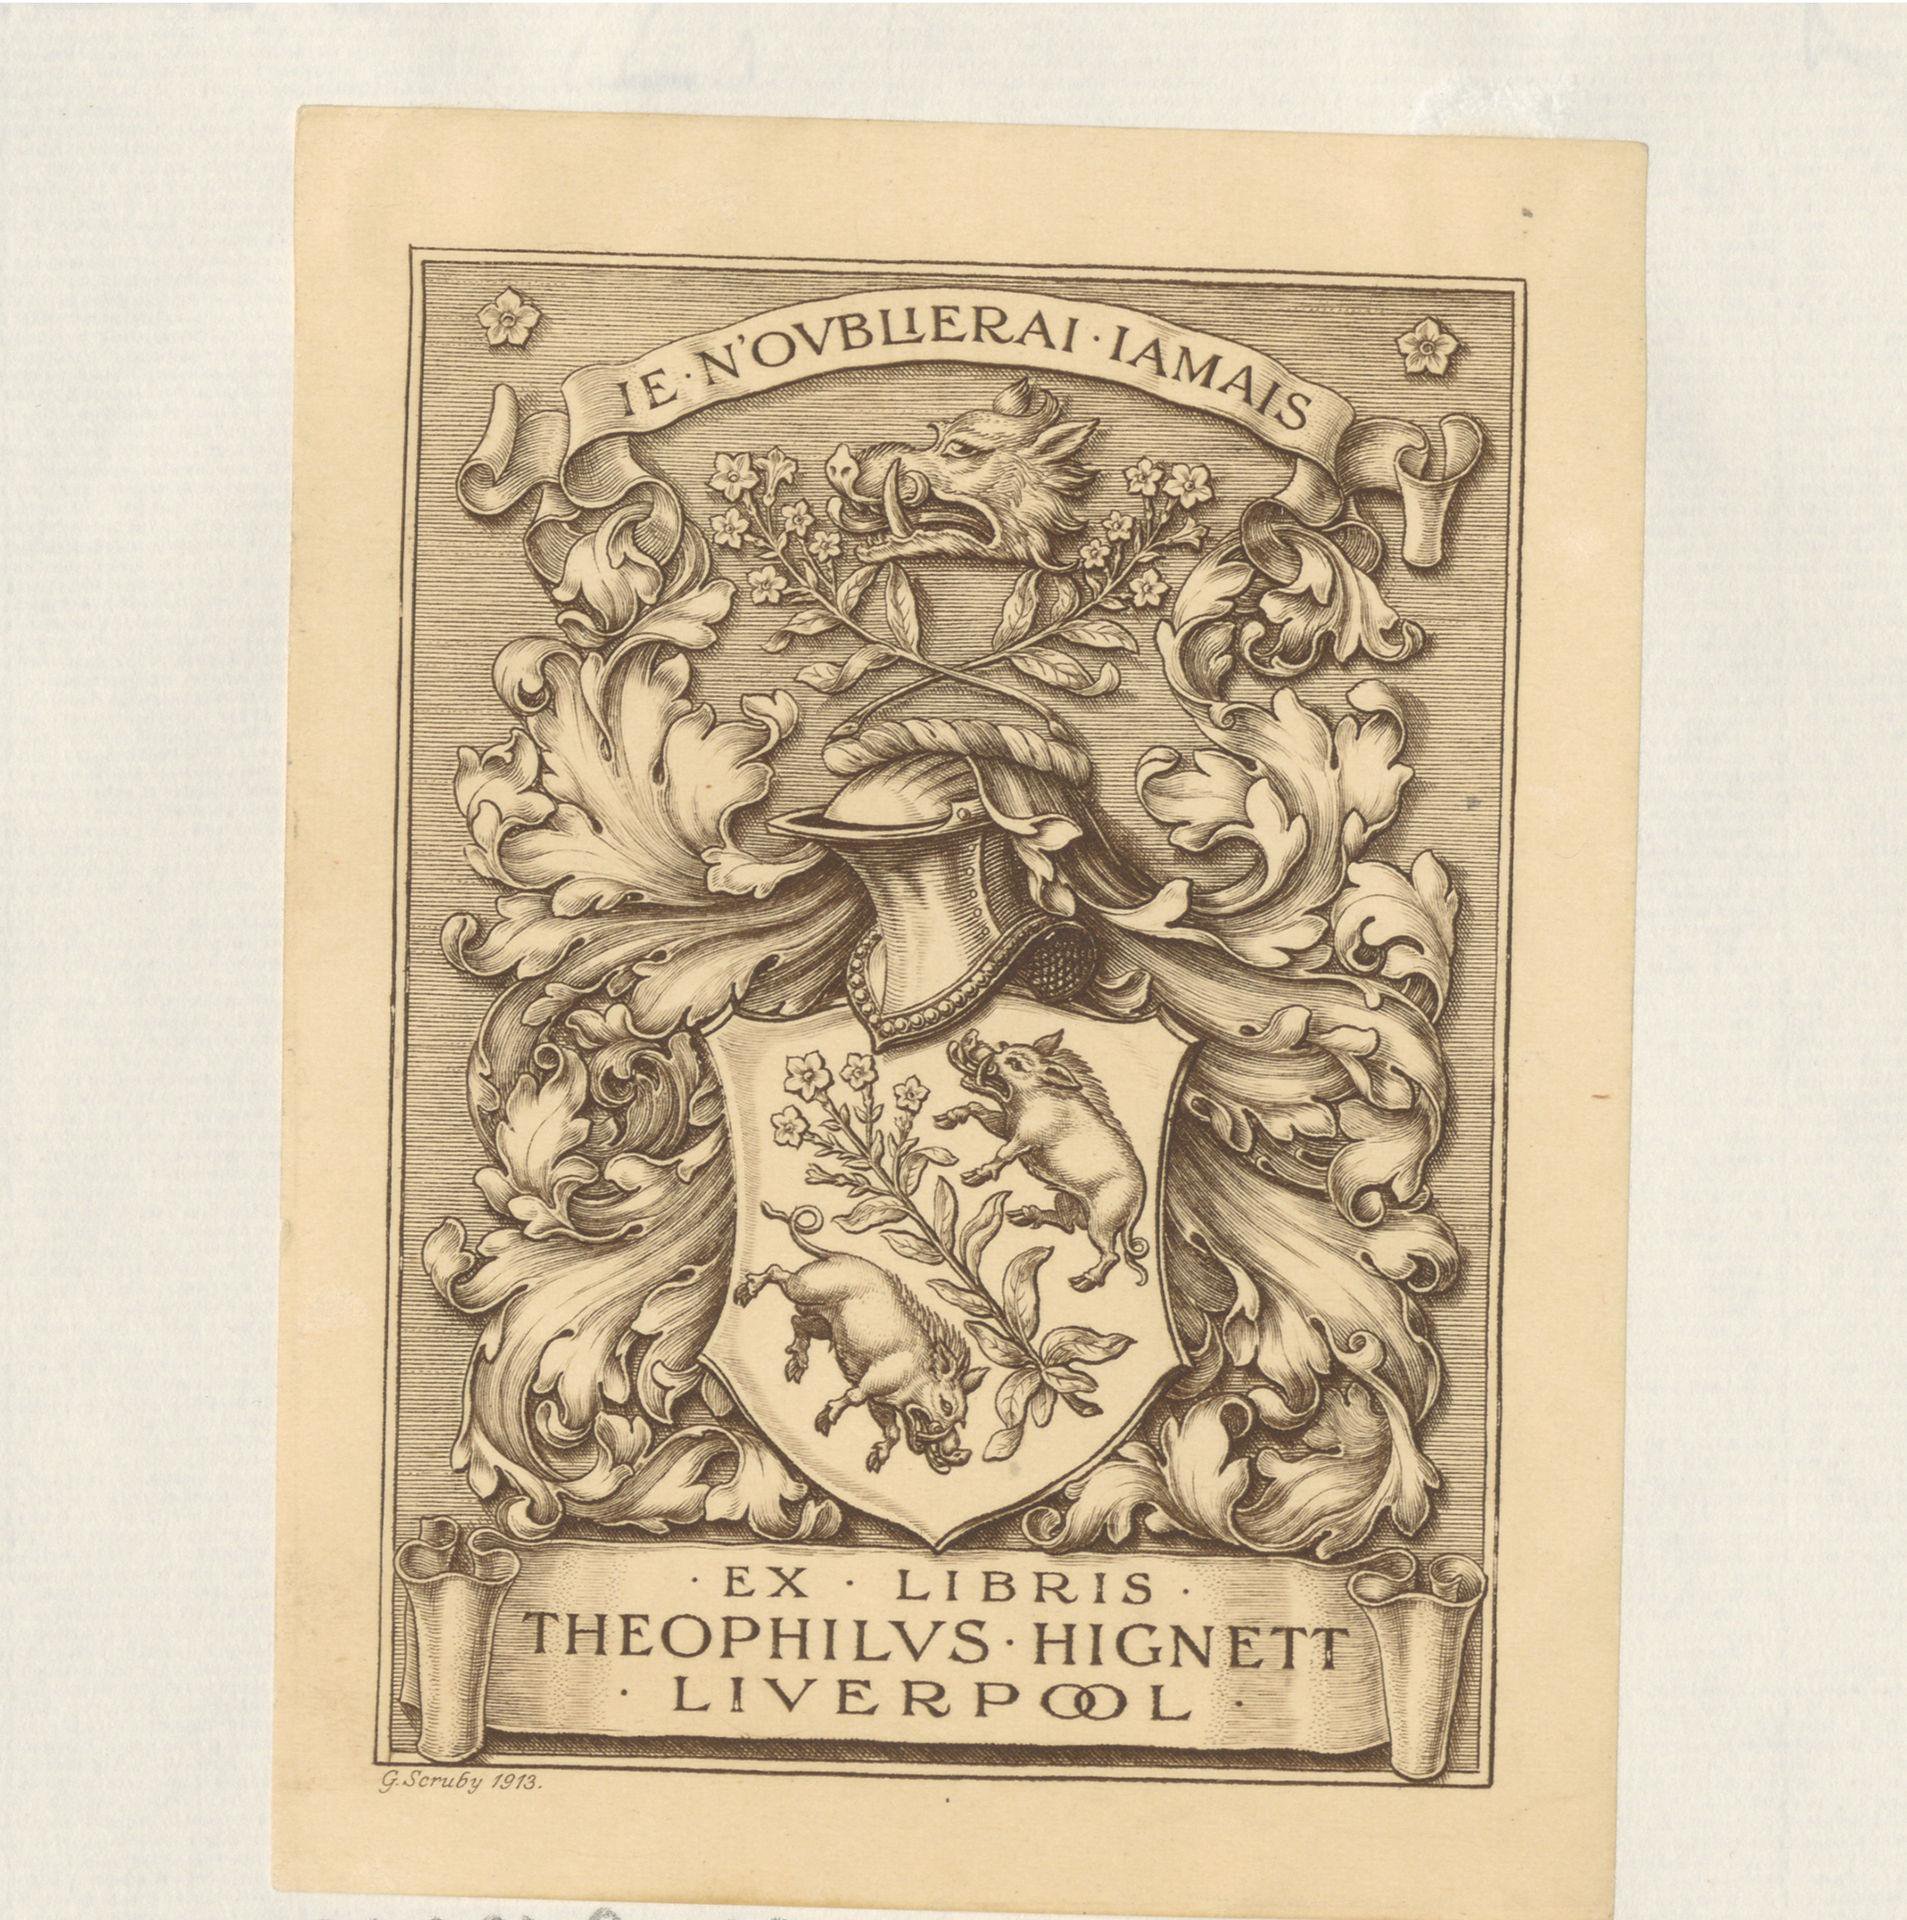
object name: bookplate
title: Ex libris Theophilus Hignett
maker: george scruby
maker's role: print maker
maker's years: -1937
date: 1913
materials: paper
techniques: engraving, etching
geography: england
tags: hoofed animals: boar, armorial bearing, heraldry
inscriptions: date